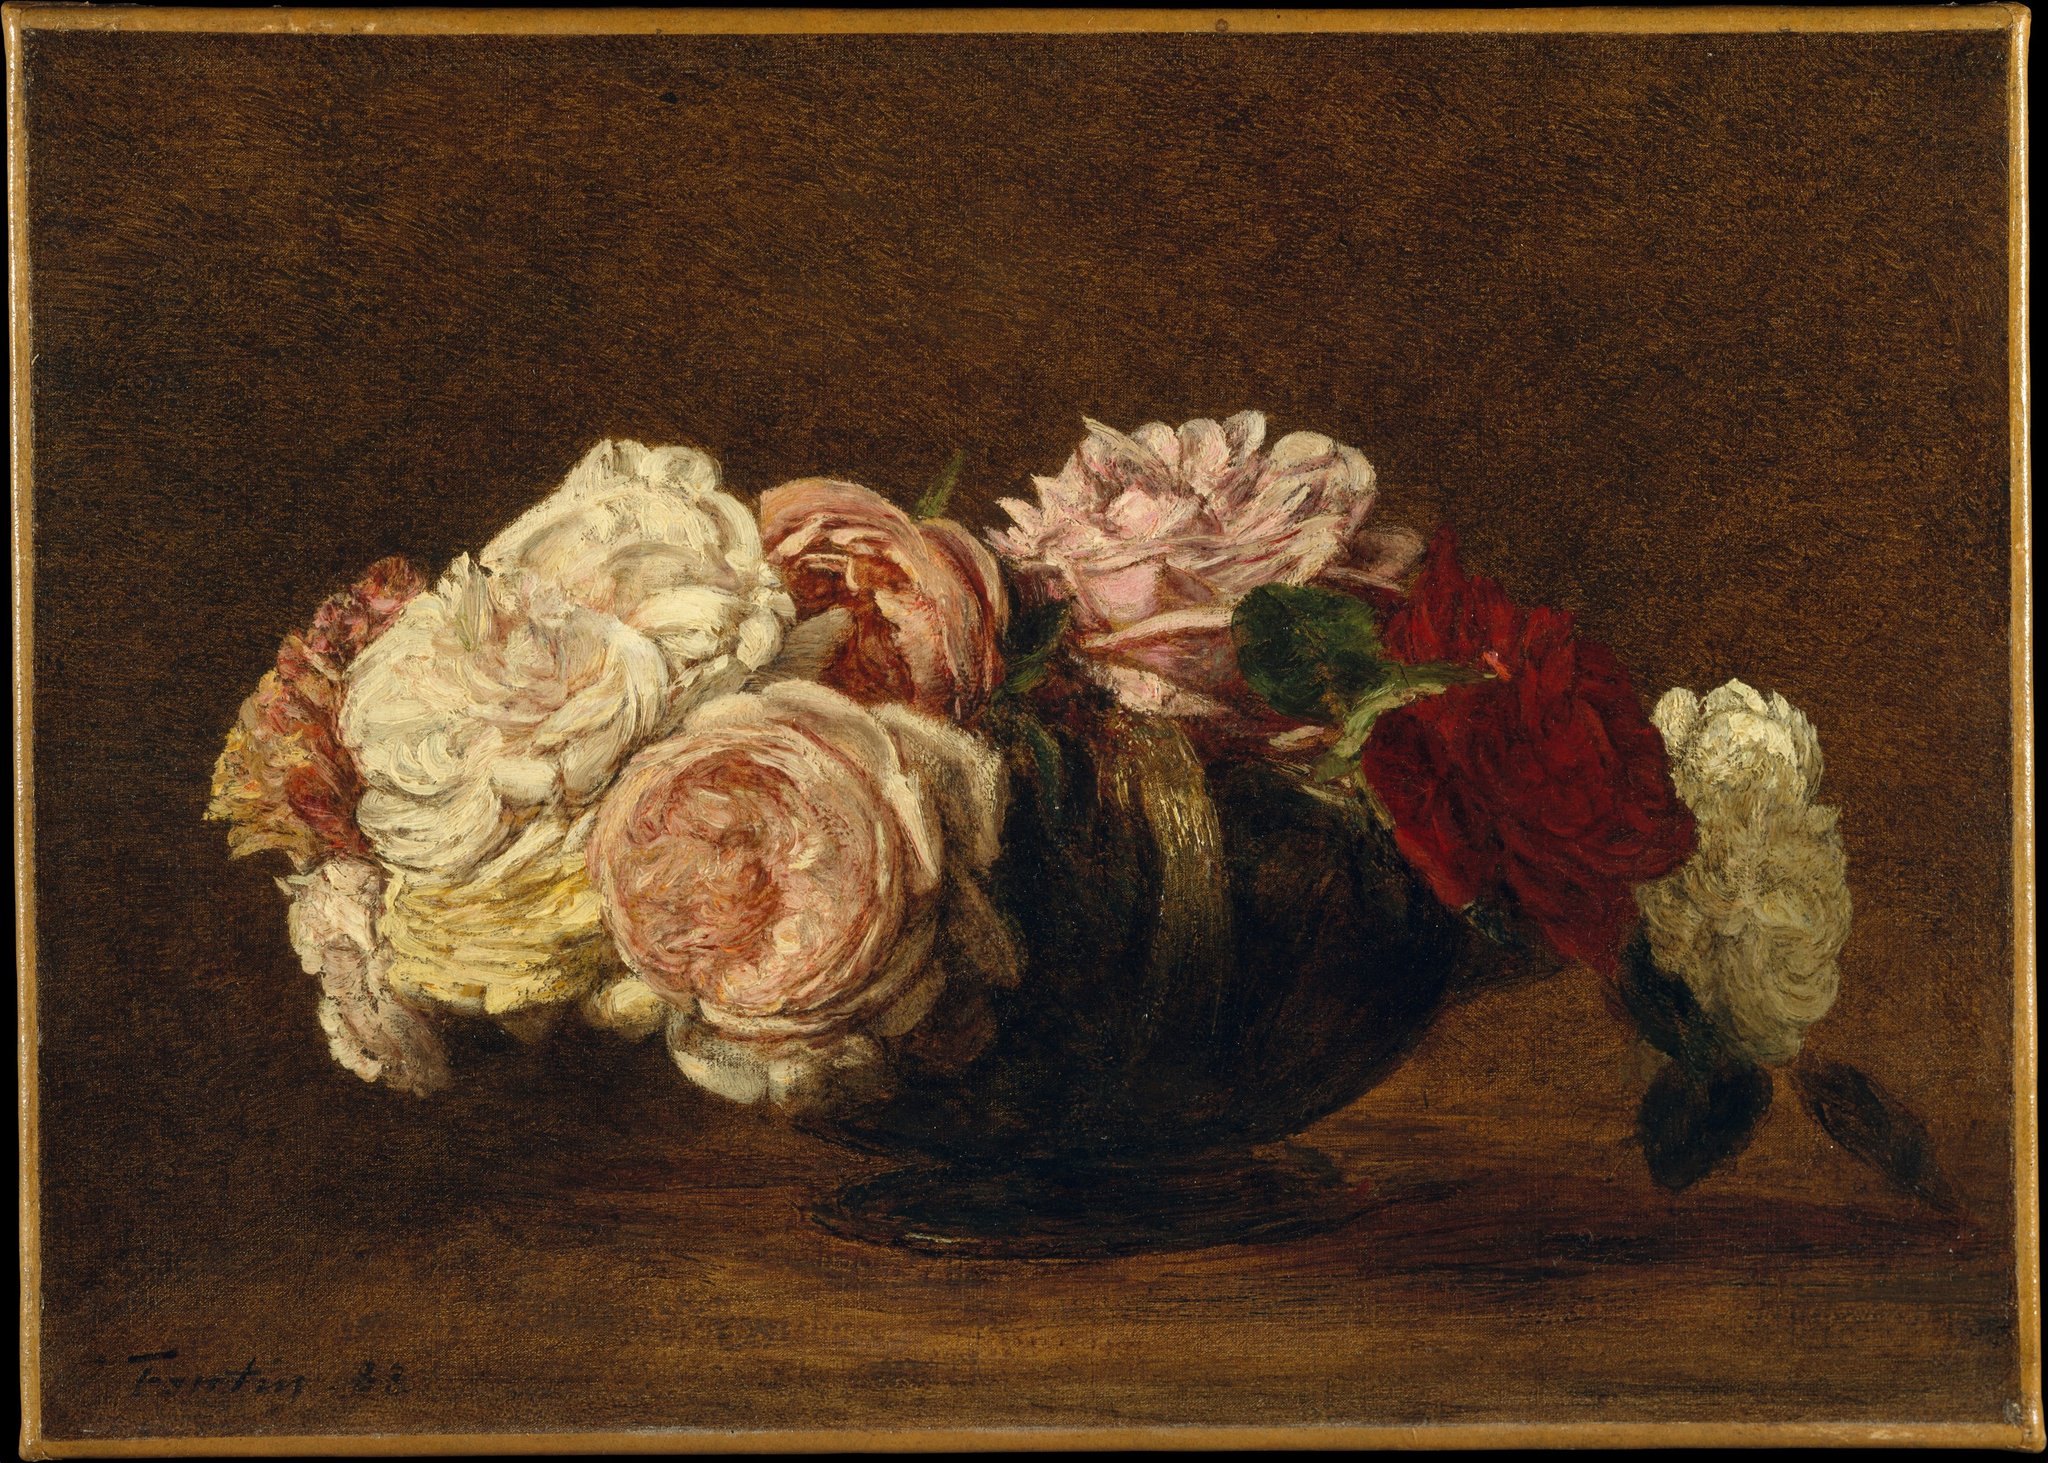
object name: painting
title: Roses in a Bowl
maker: henri fantin-latour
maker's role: artist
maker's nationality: french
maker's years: 1836-1904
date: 1883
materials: canvas, oil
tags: roses,still life